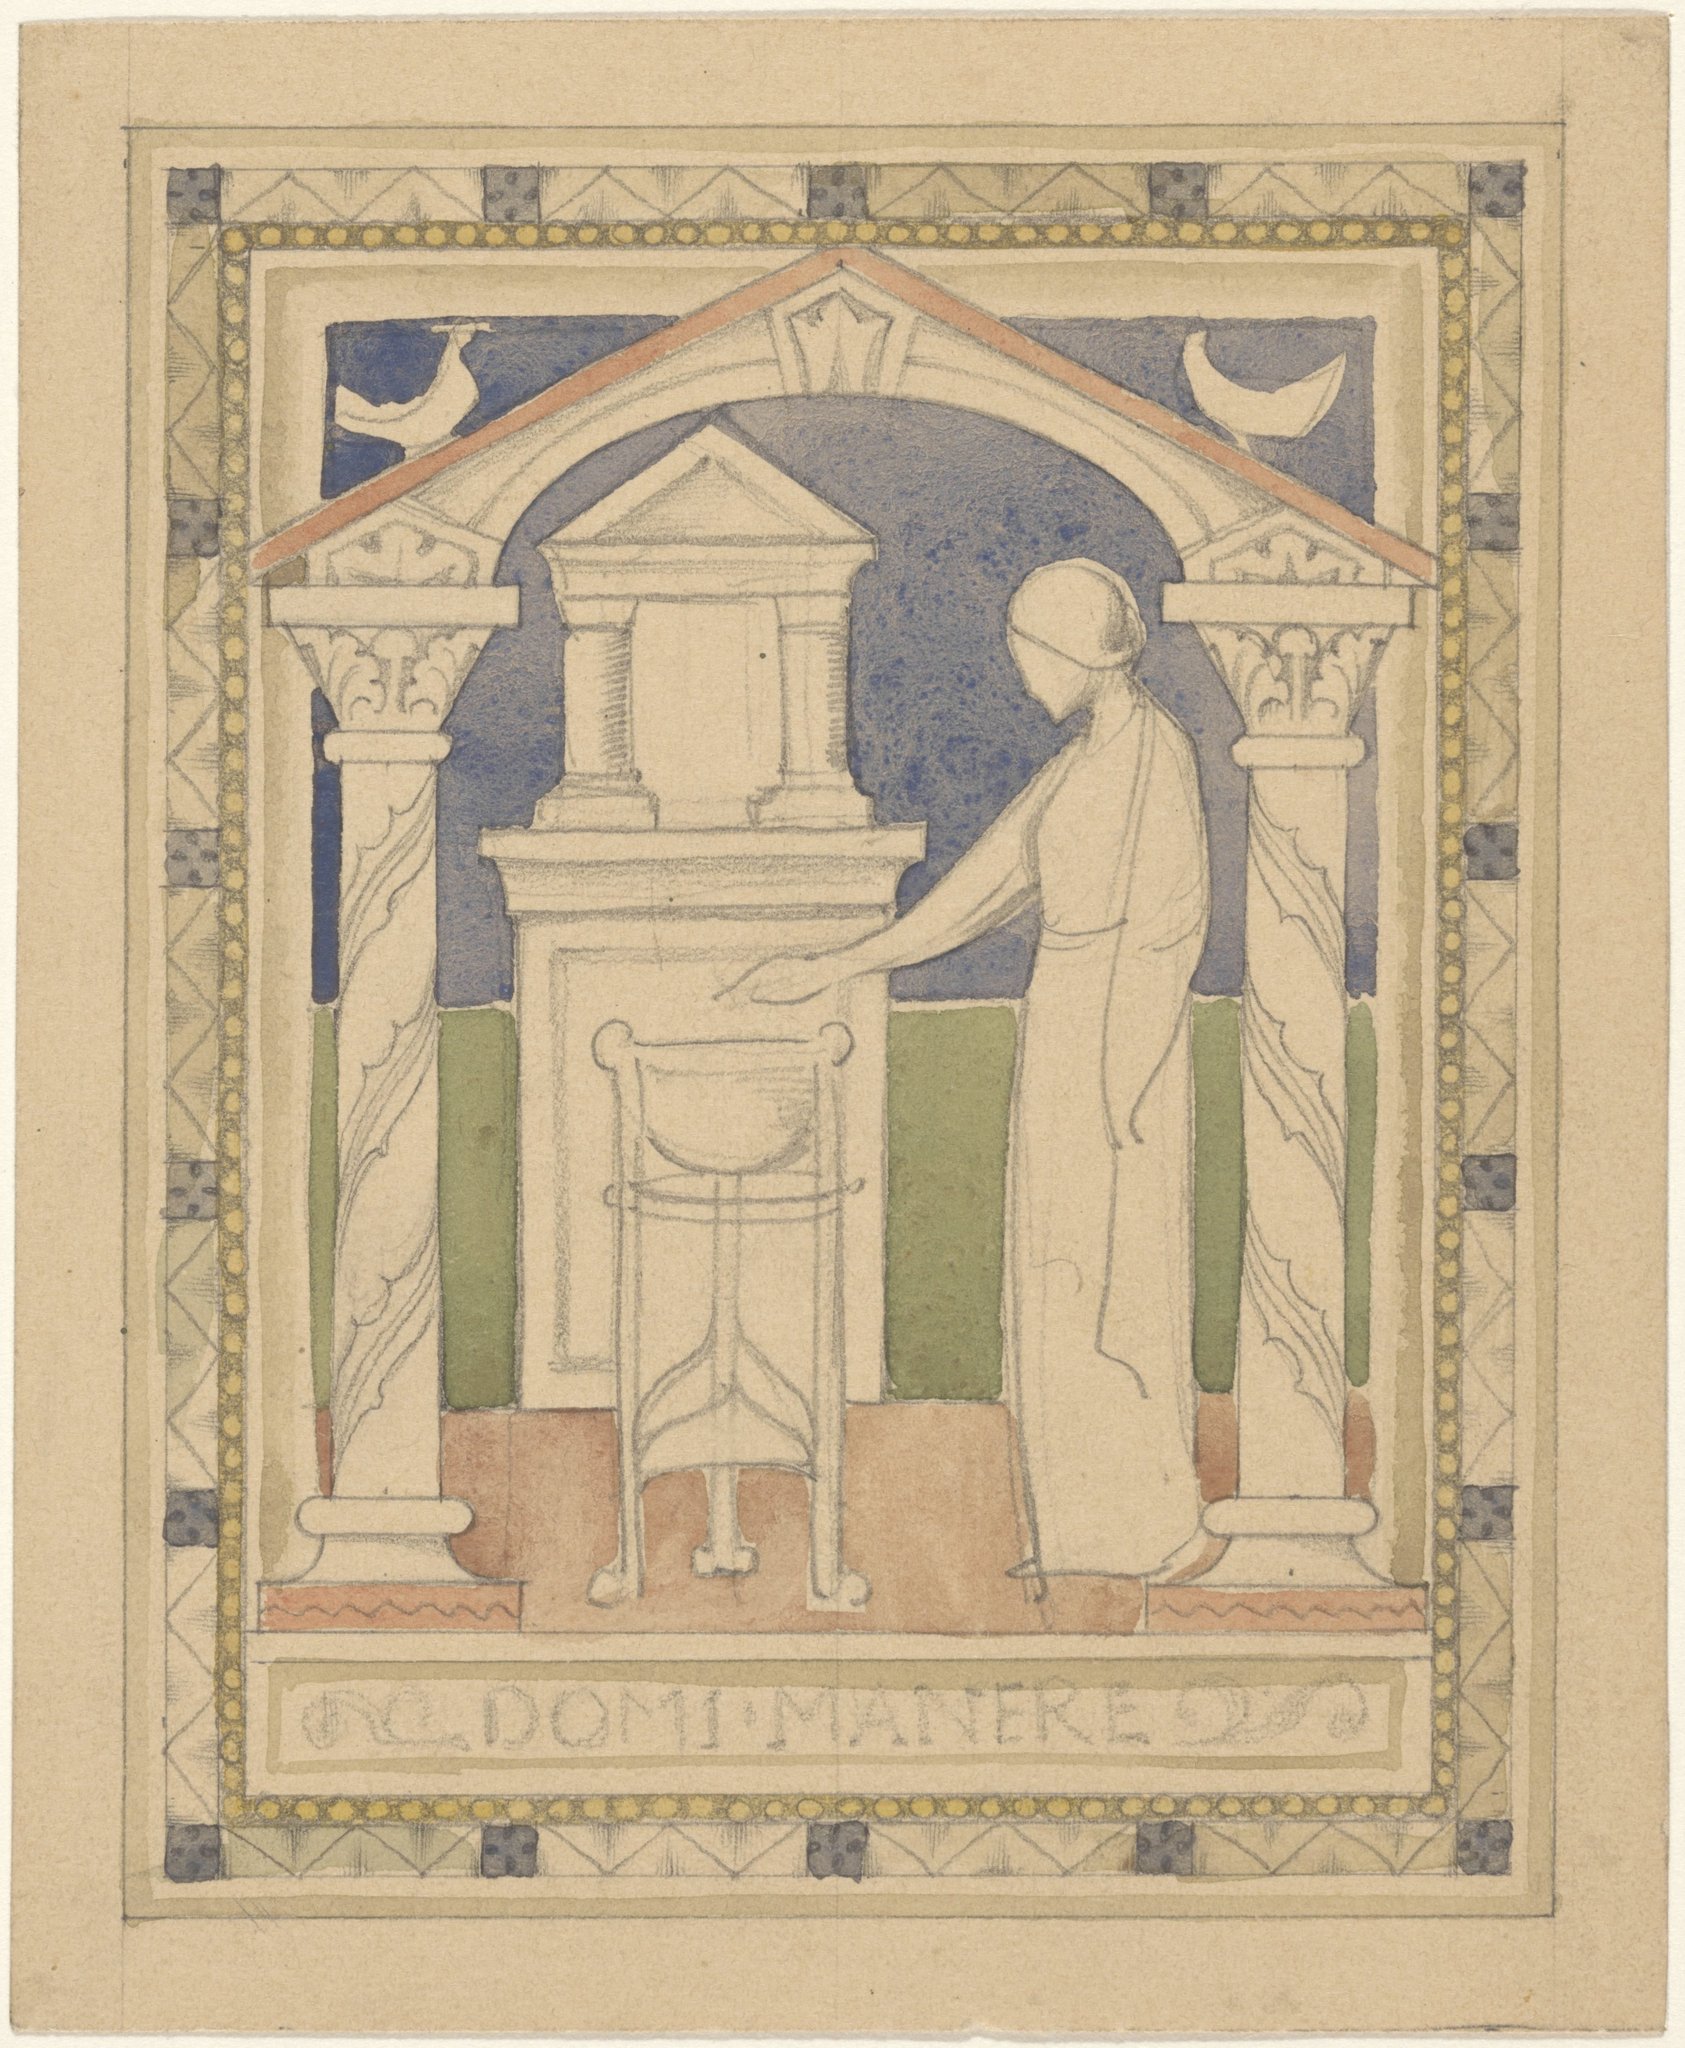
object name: watercolor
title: Domi Manere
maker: antoon derkinderen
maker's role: draughtsman, painter, print maker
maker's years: 1859-1925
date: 1869-1925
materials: paper, pencil, watercolor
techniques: brush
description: Ontwerp voor glasschildering in het huis van S. de Swart en Em. van Kerckhoff te Laren: Domi Manere.